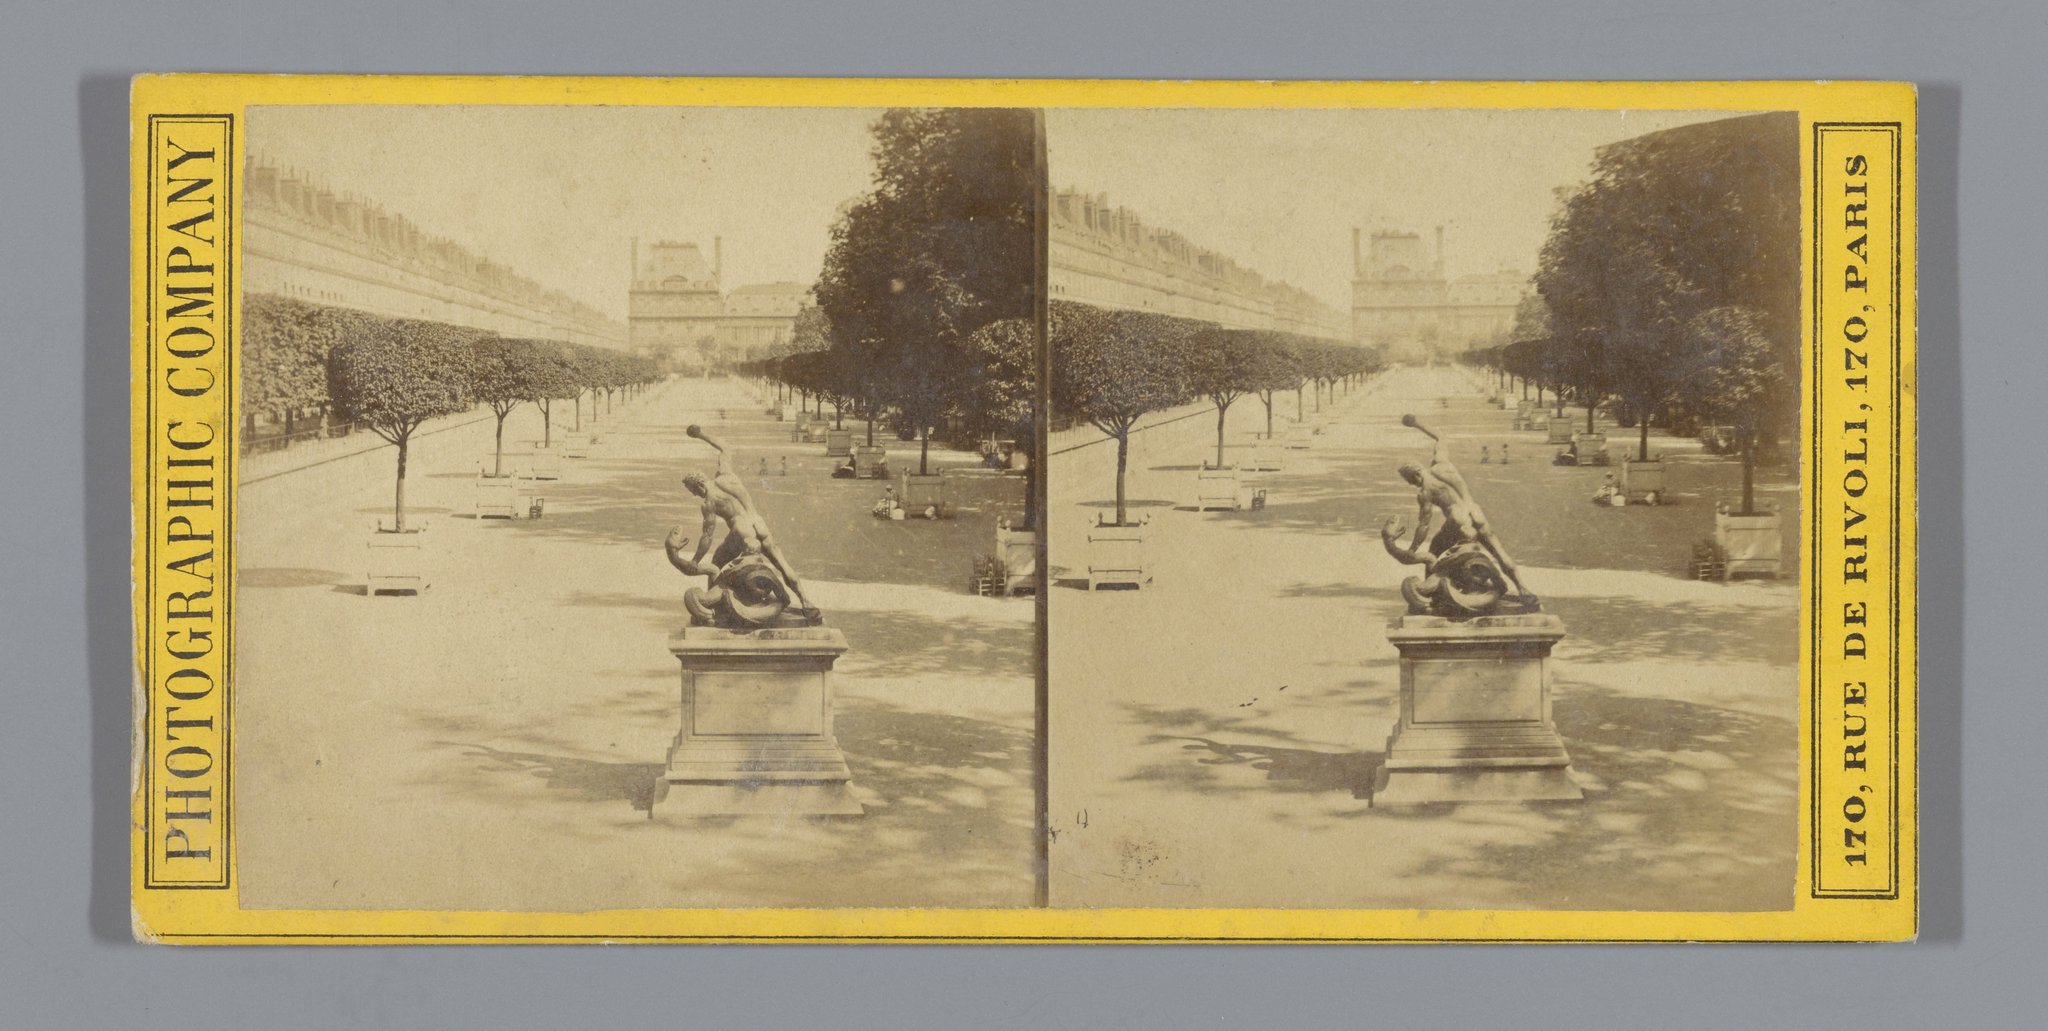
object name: stereograph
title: Laan in de Jardin des Tuileries te Parijs, met op de achtergrond het Palais des Tuileries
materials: cardboard, photographic support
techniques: albumen print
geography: jardin des tuileries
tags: french or architectonic garden; formal garden, lane, alley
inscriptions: inscription: ‘Jardin des Tuileries’